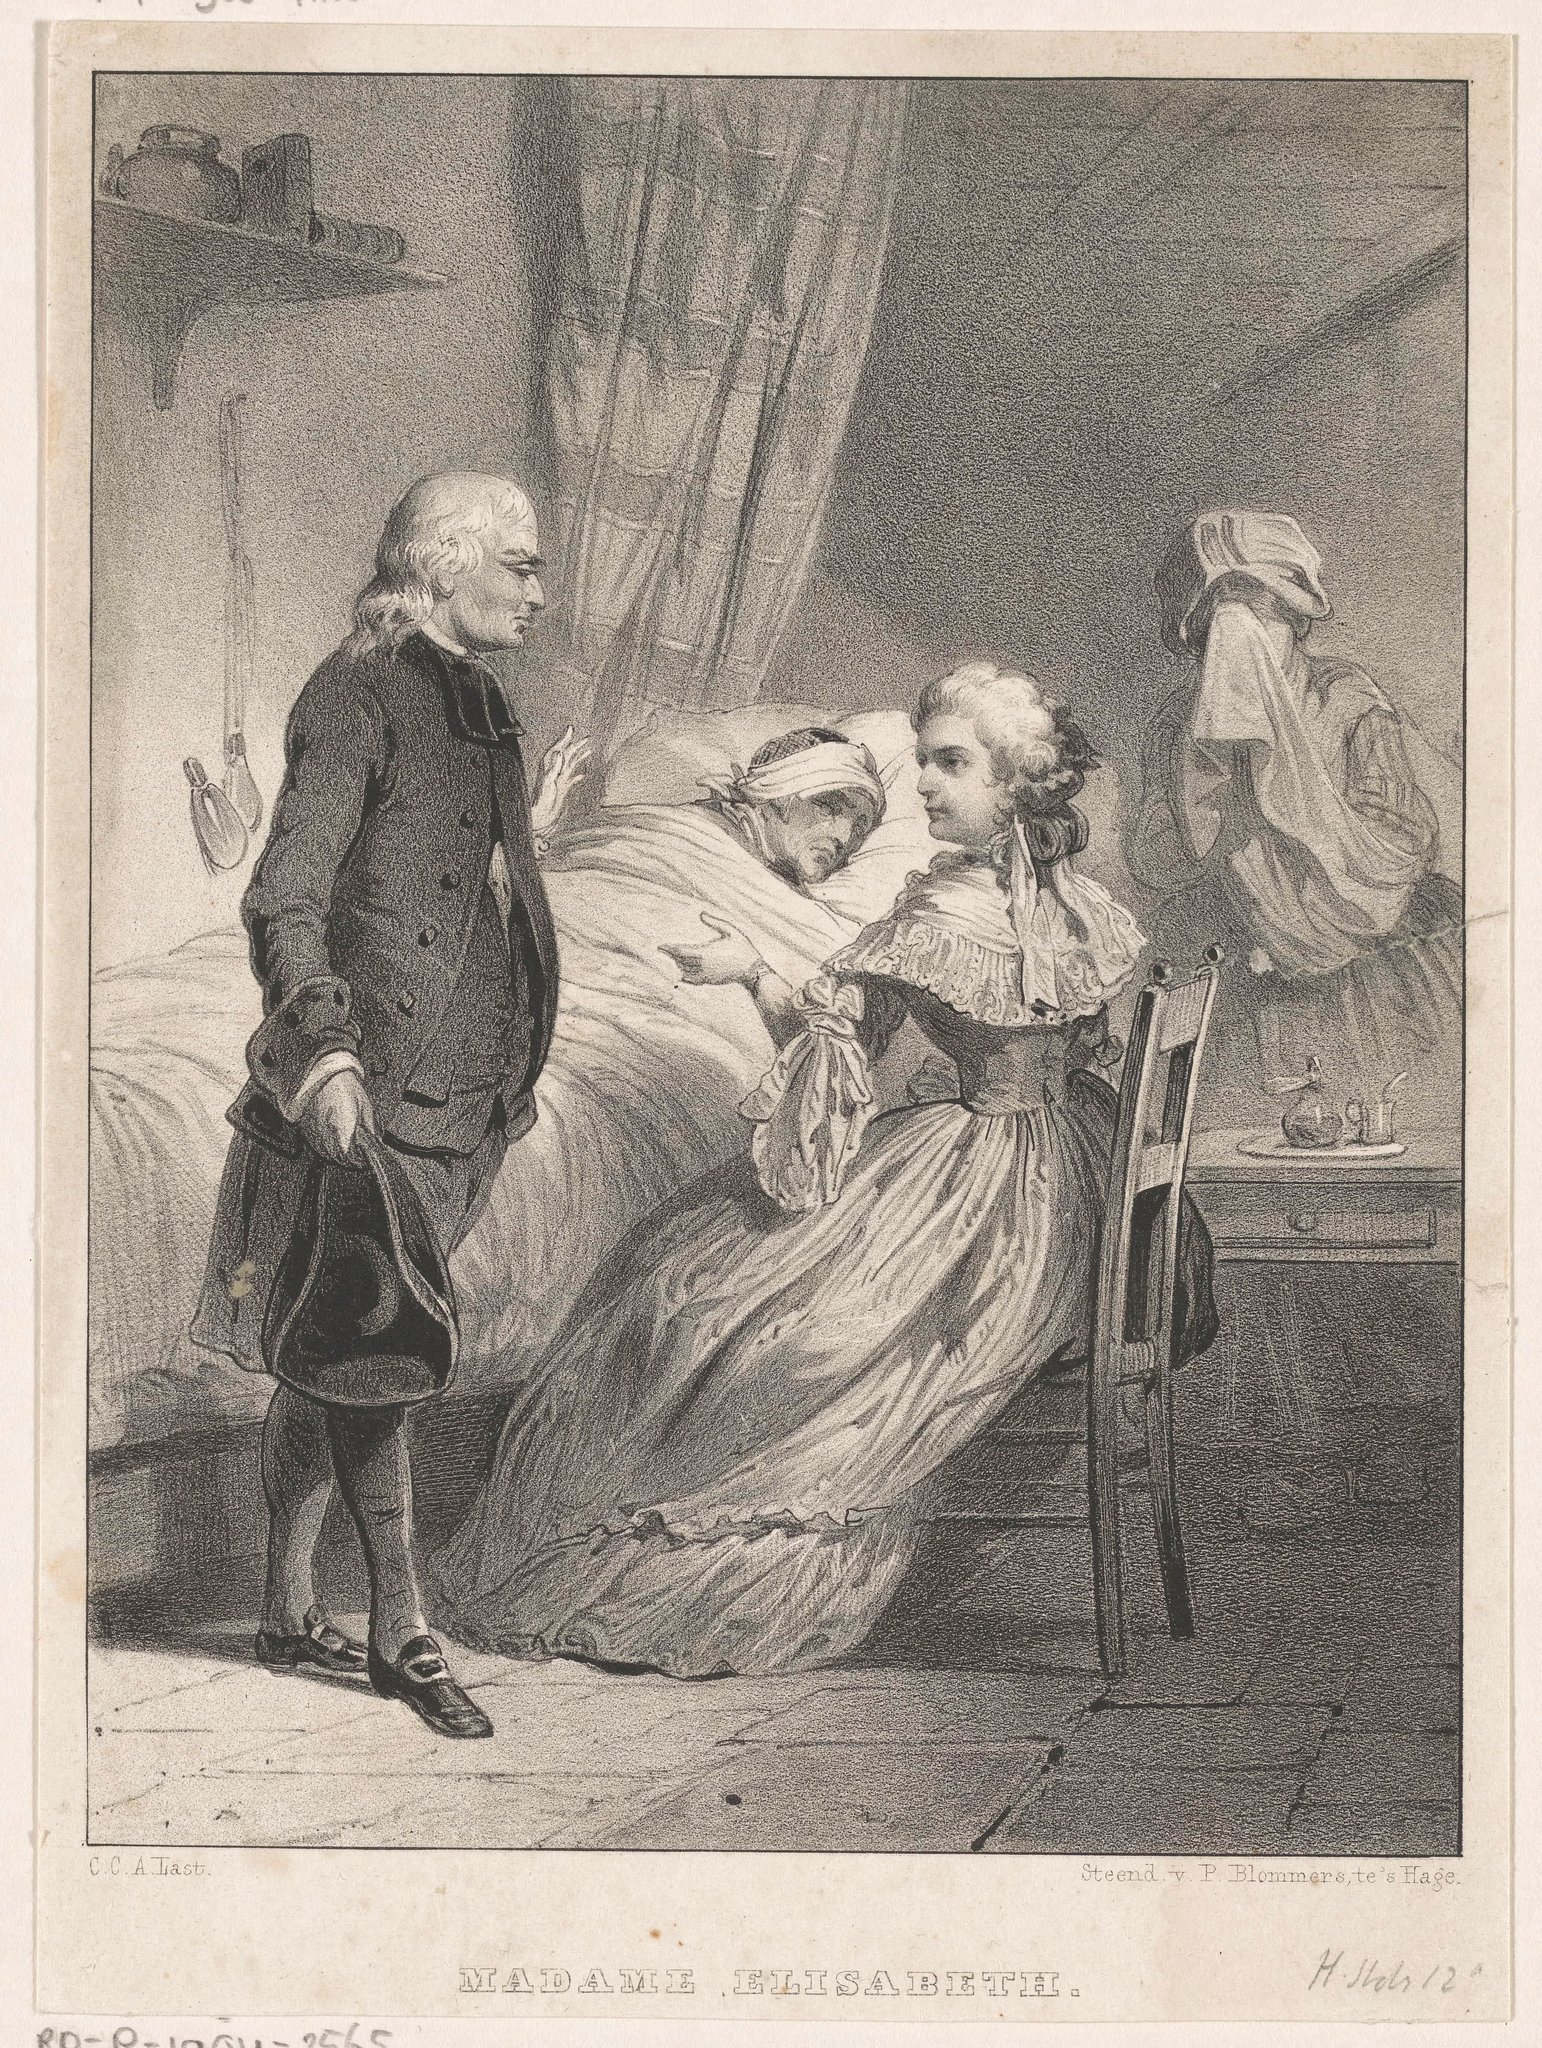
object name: print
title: Elisabeth van Frankrijk aan het bed van een zieke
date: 1842-1887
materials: paper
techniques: lithograph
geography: the hague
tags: weeping, visiting the sick; sick person together with others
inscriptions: collector's mark: Lugt 2228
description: De prinses zit naast het bed van een zieke man. Achter haar een huilende vrouw. Links een gezant die zijn hoed heeft afgenomen.